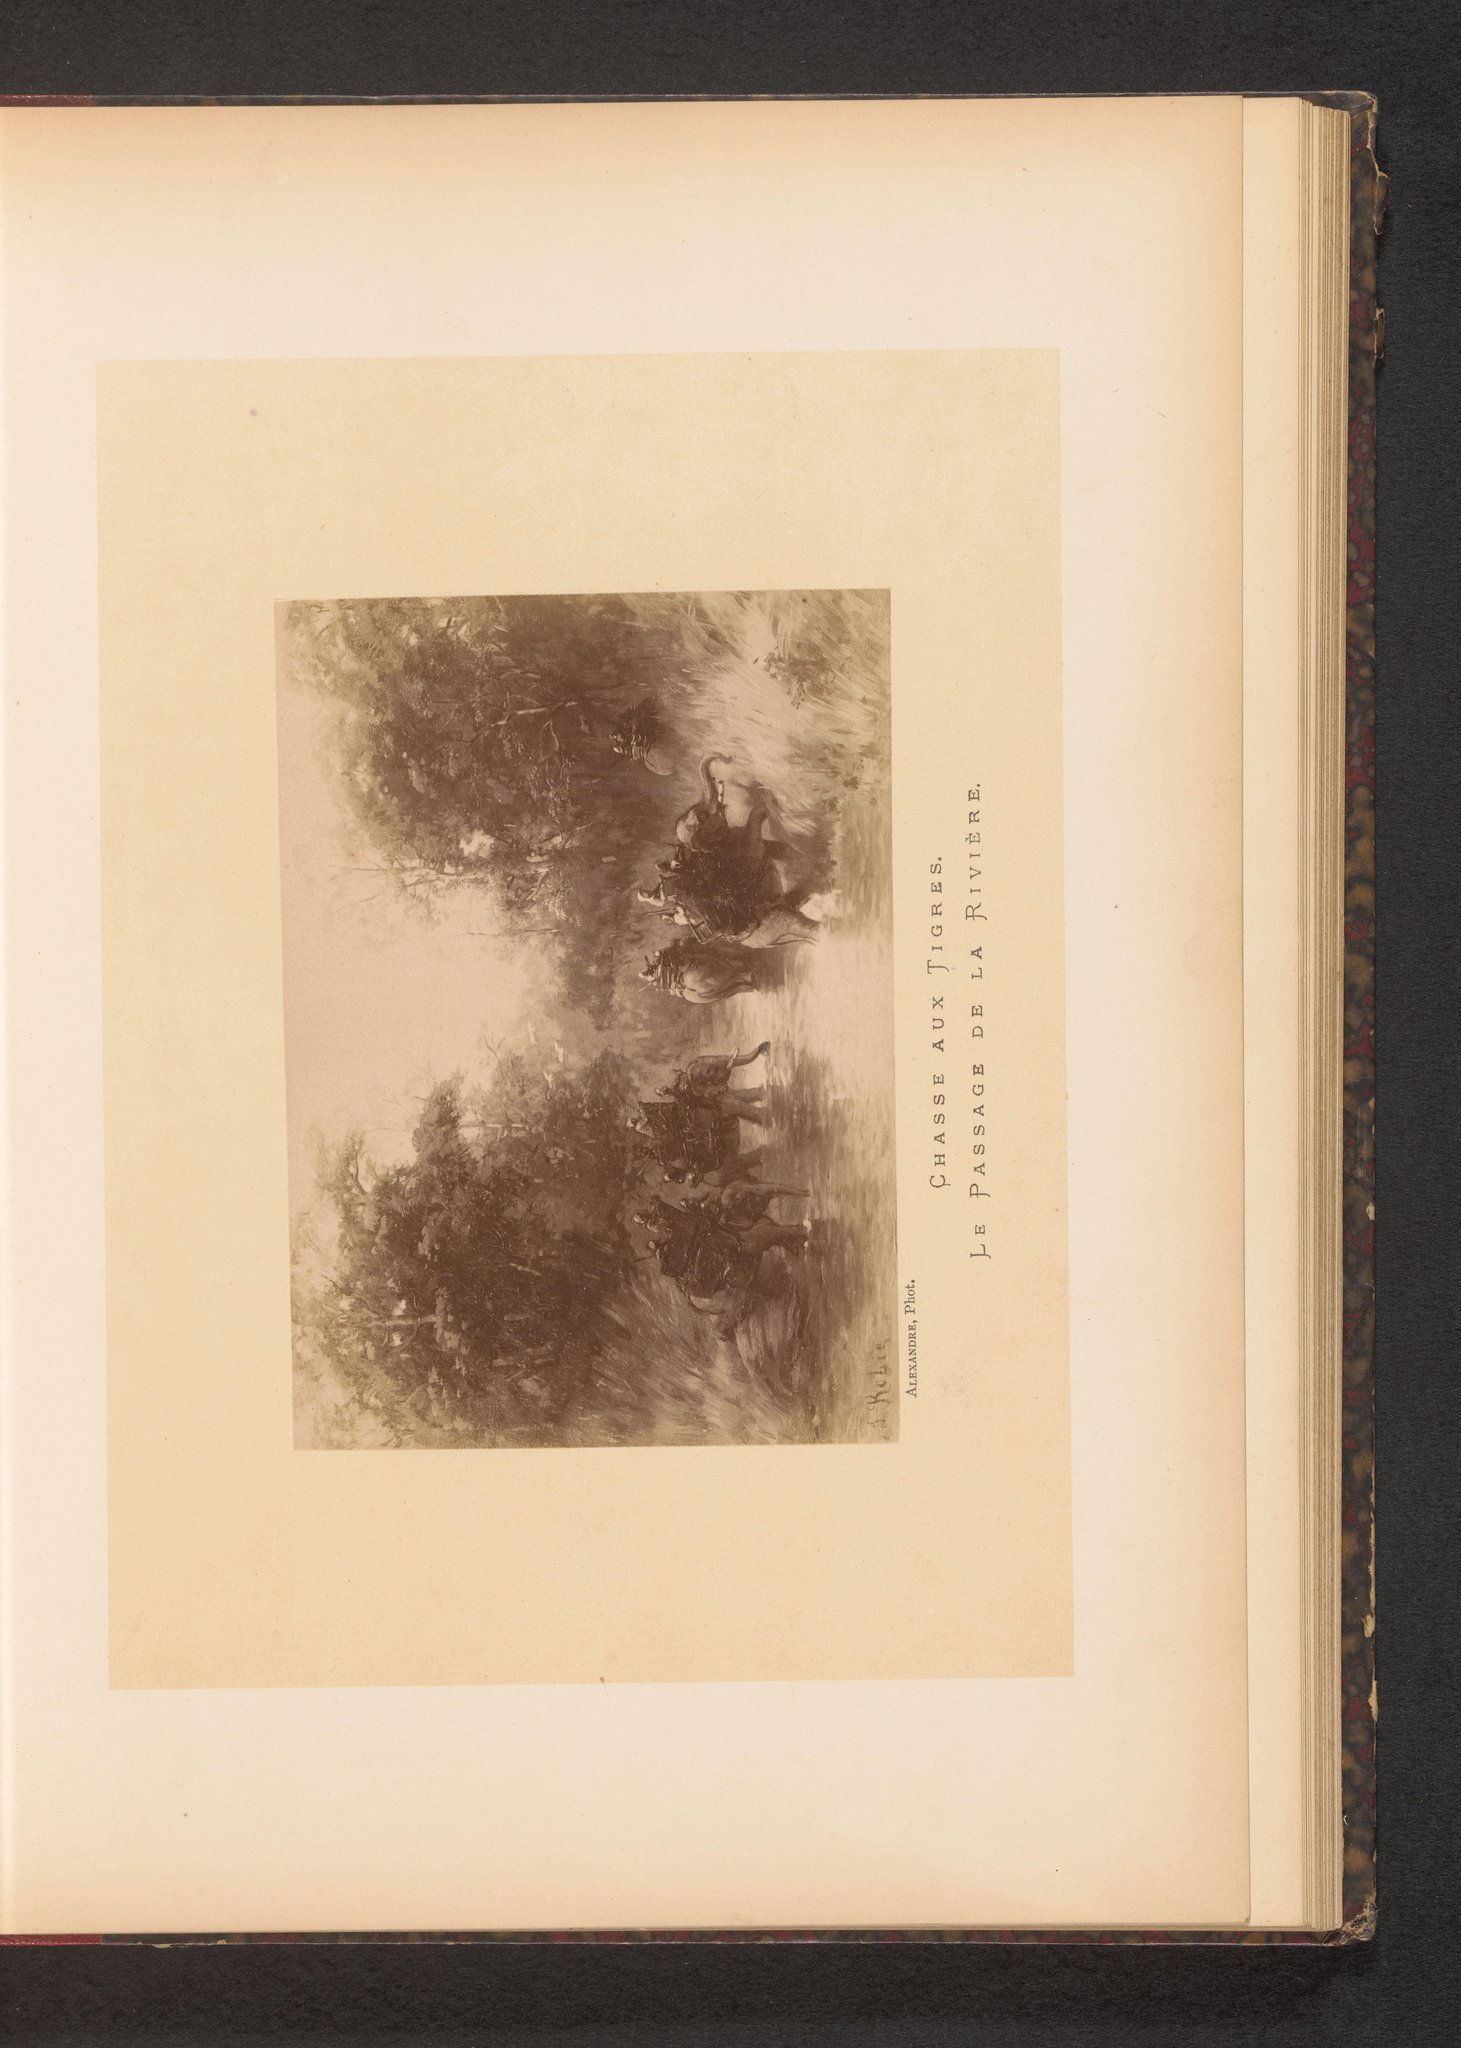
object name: photograph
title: Chasse aux Tigres./ Le Passage de la Rivière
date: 1878-1883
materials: photographic support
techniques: albumen print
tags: hunt ~ predatory animals (fox, lion)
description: Foto tegenover pagina 64, achter omslag.